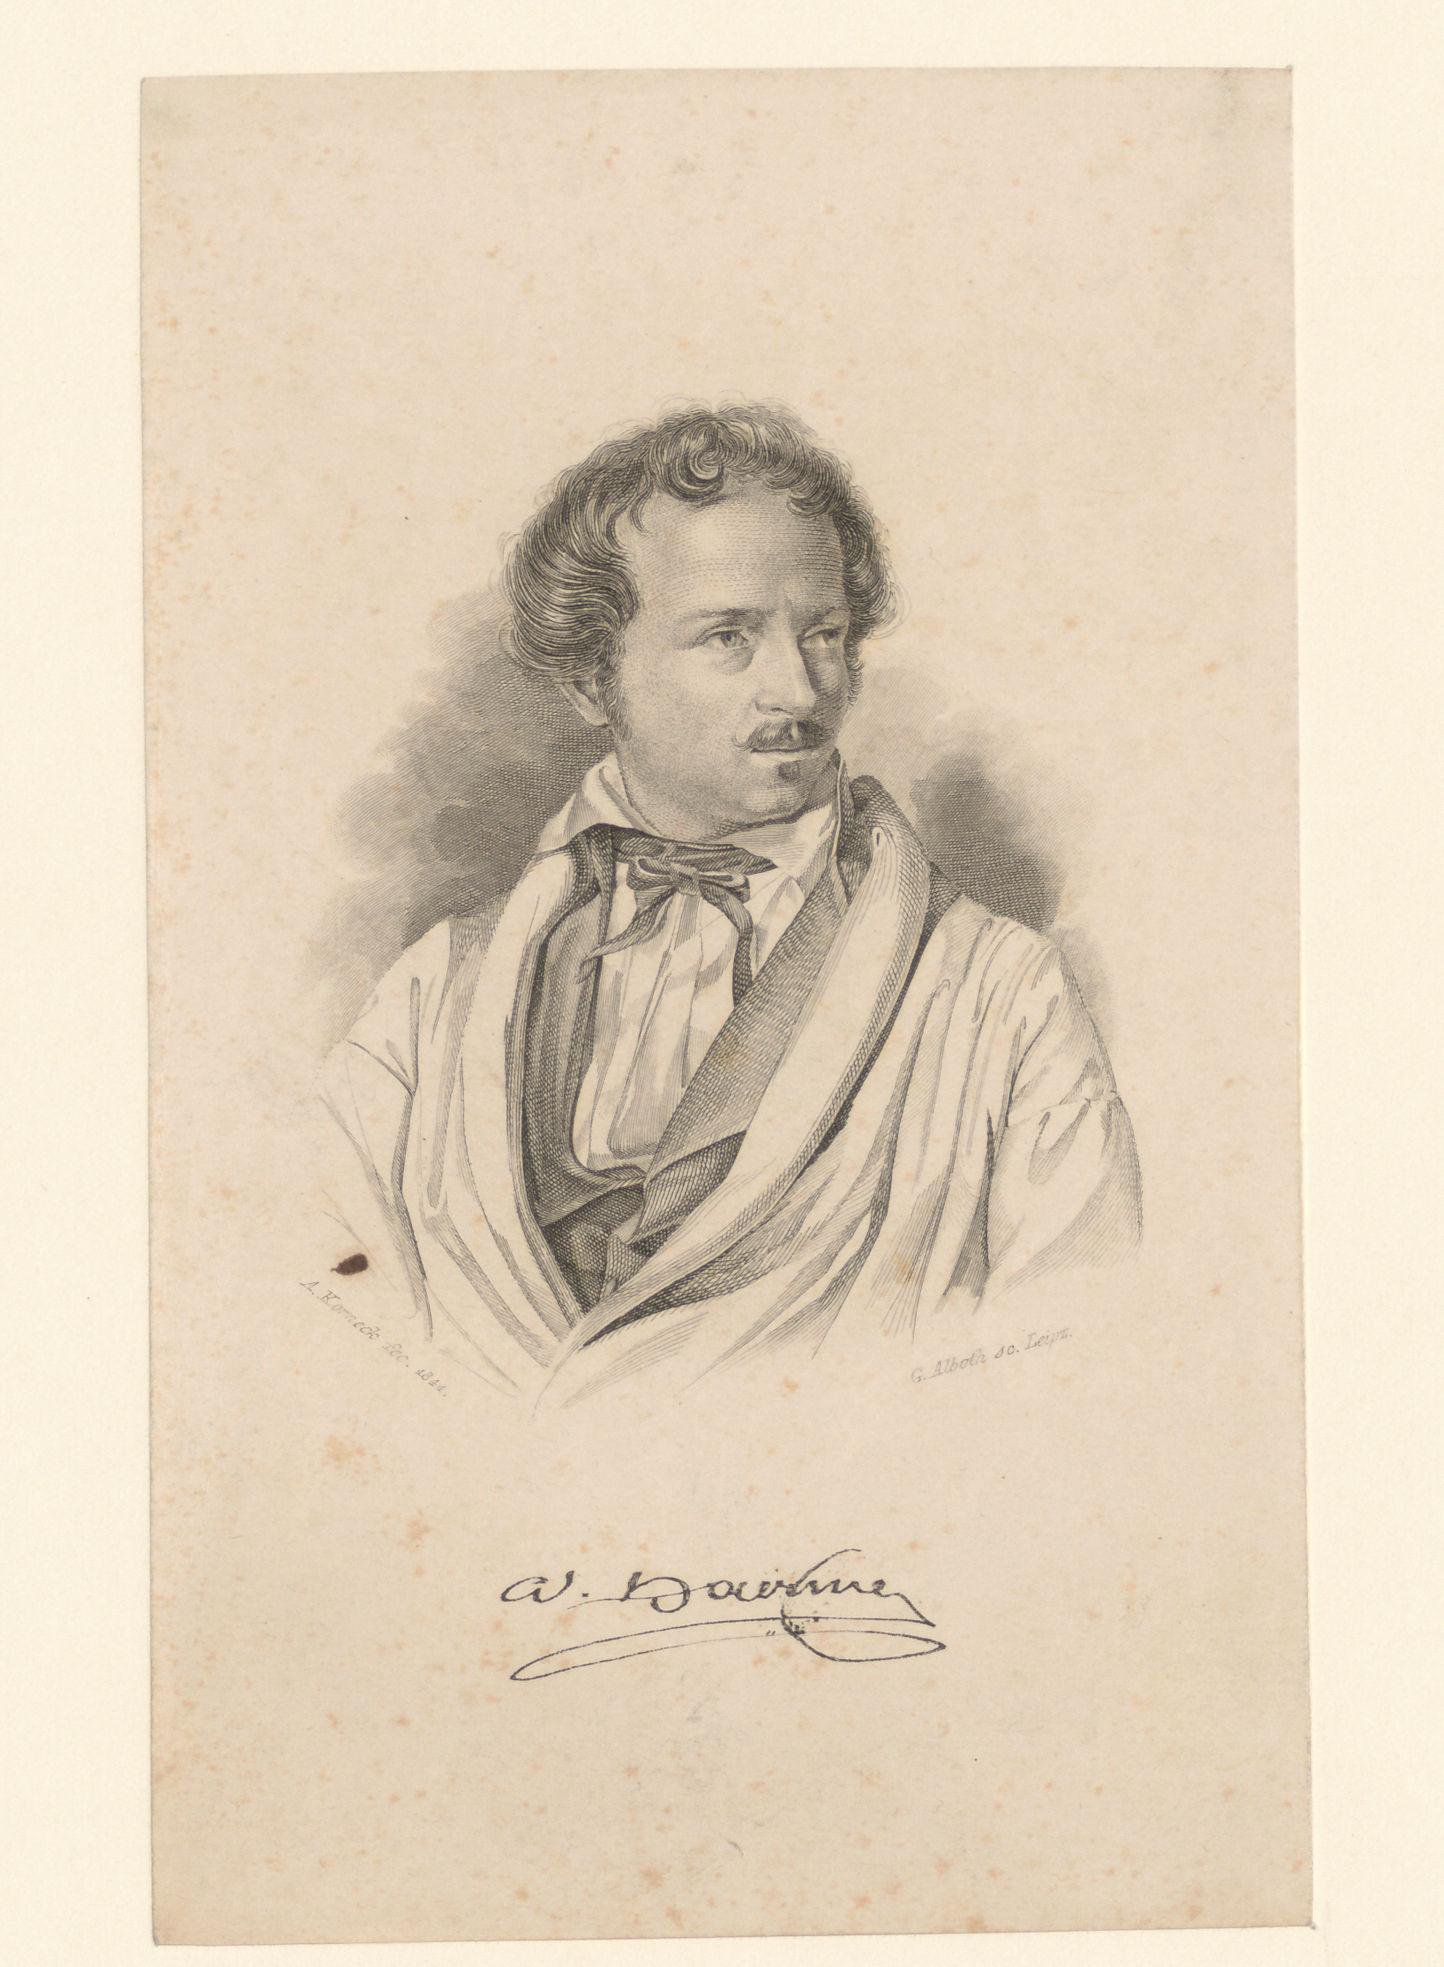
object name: print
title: Portret van Willibald Alexis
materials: paper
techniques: etching, engraving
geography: leipzig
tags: historical persons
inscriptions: collector's mark: Lugt 2228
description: De eigenlijke naam van de geportretteerde was George Wilhelm Heinrich Häring. Dit verklaart de signatuur 'W. Haering' onder het portret.